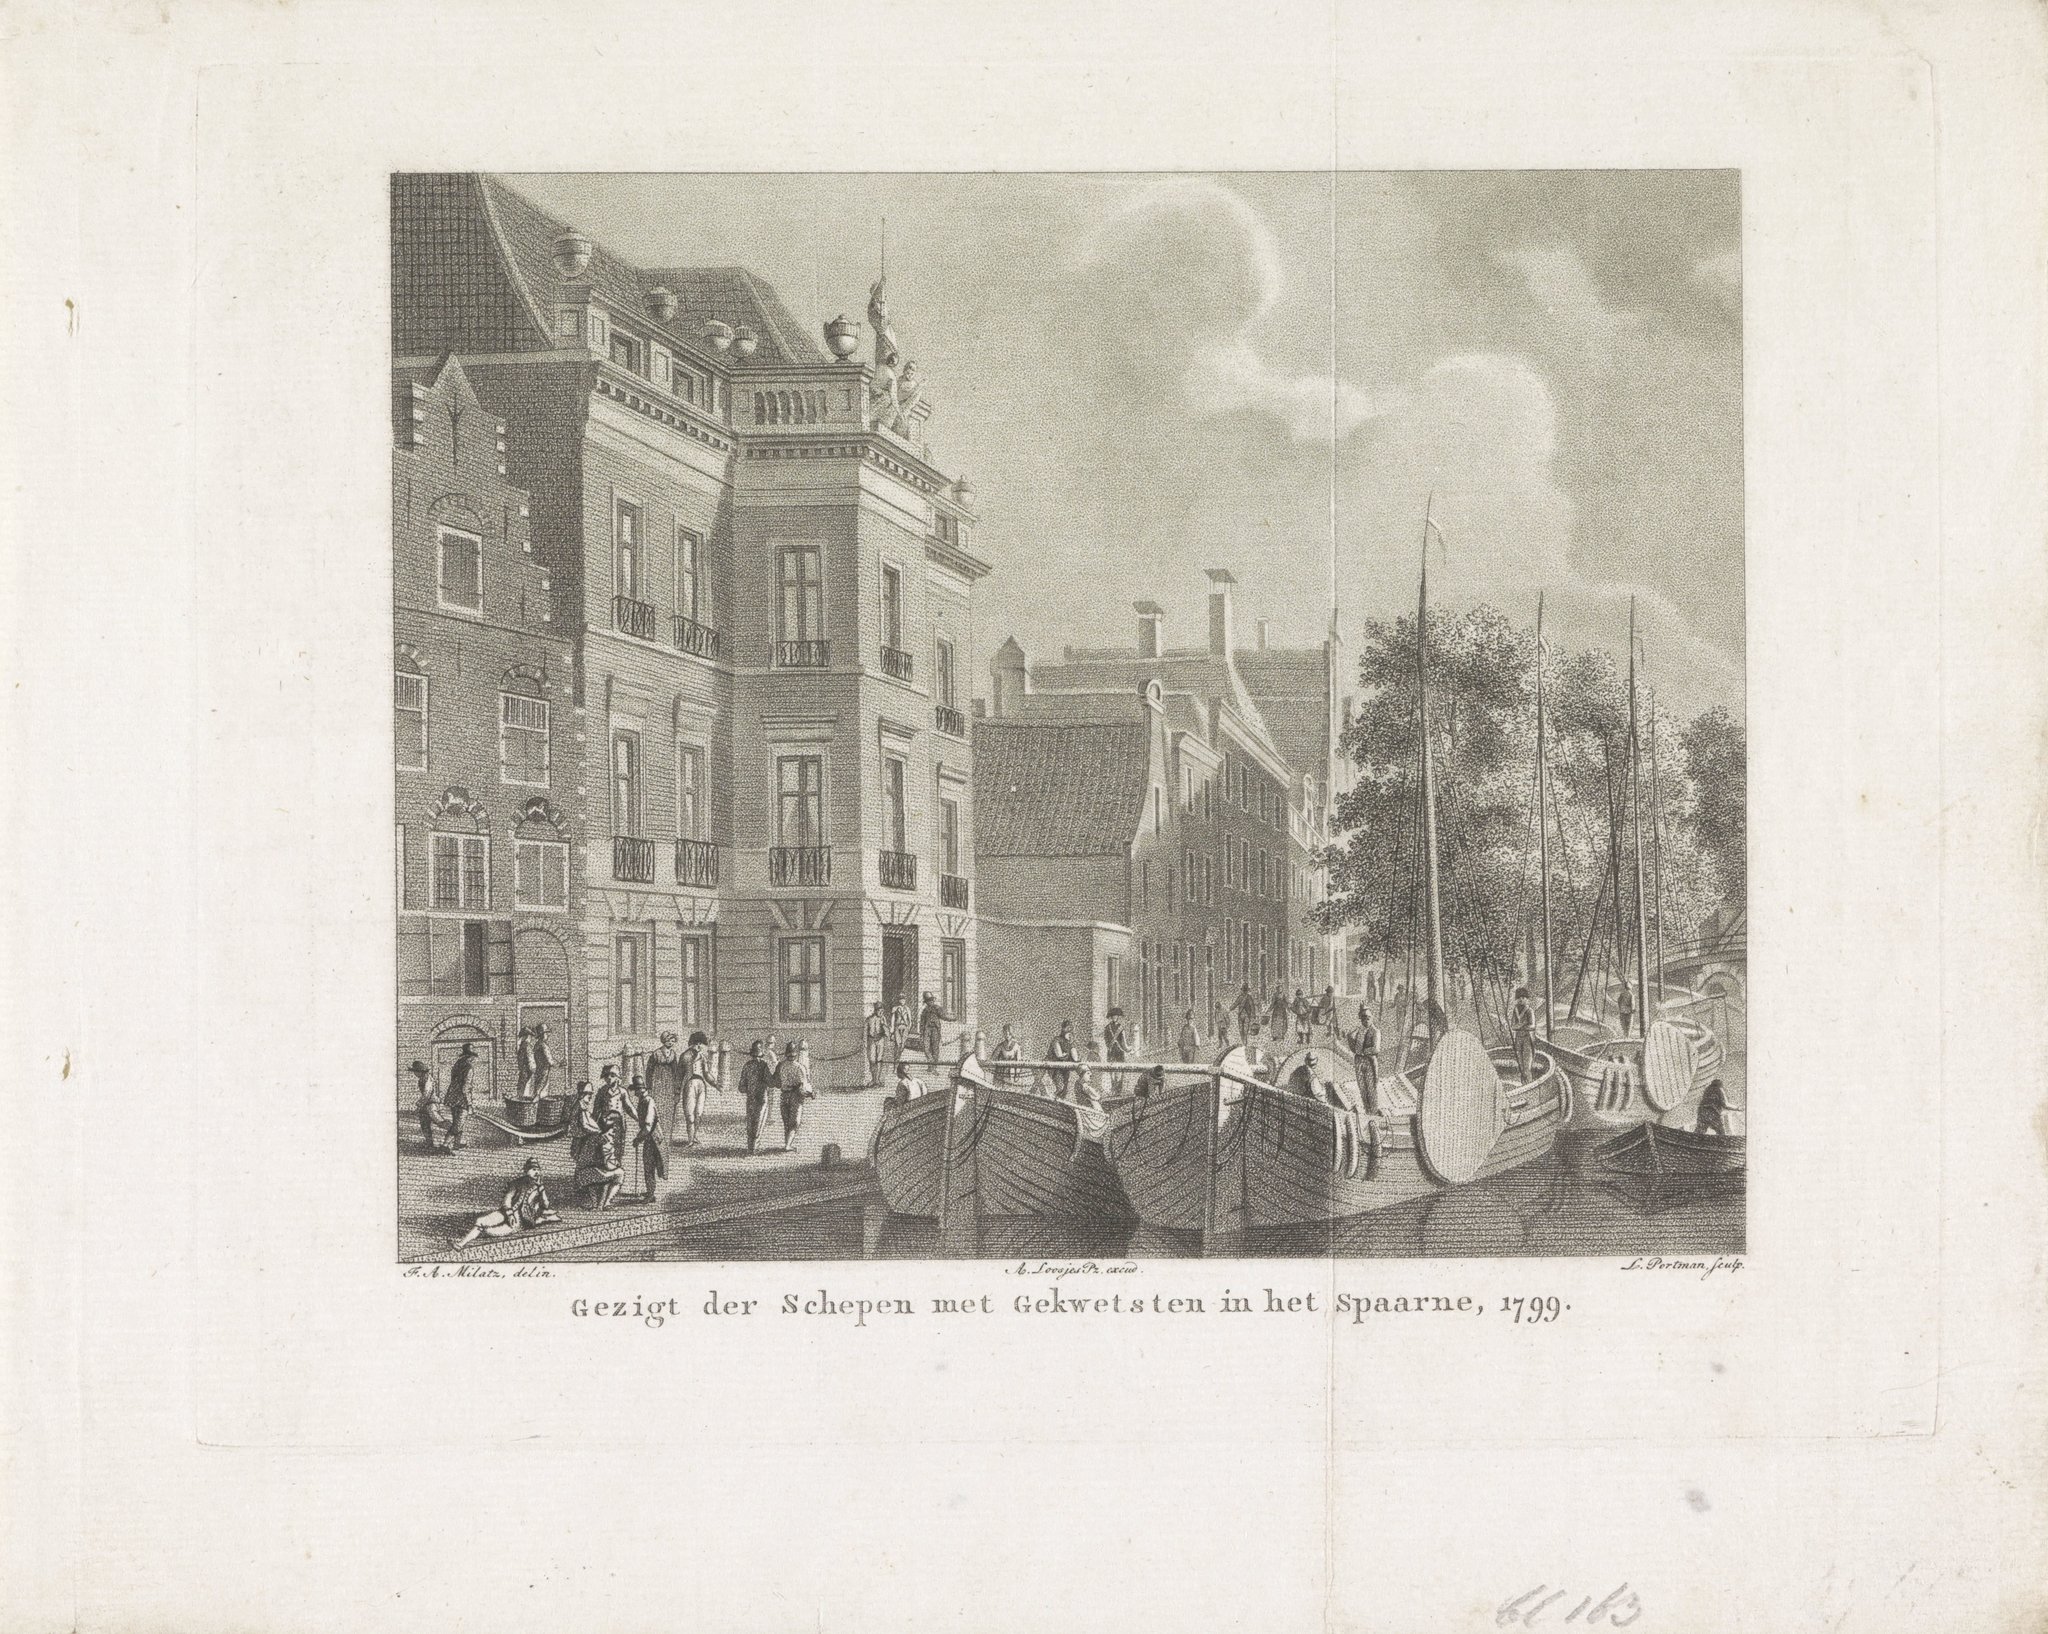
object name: print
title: Gezigt der Schepen met Gekwetsten in het Spaarne, 1799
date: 1801-1803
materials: paper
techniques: engraving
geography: netherlands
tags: transport of the sick, wounded and dead by vehicle, haarlem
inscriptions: collector's mark: Lugt 2228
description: Gebruikt als illustratie in: Adriaan Loosjes Pz., Geschiedkundig gedenkstuk van het voorgevallene binnen Haarlem in de laatste helft van het jaar 1799. Haarlem: Adriaan Loosjes Pz., 1803.